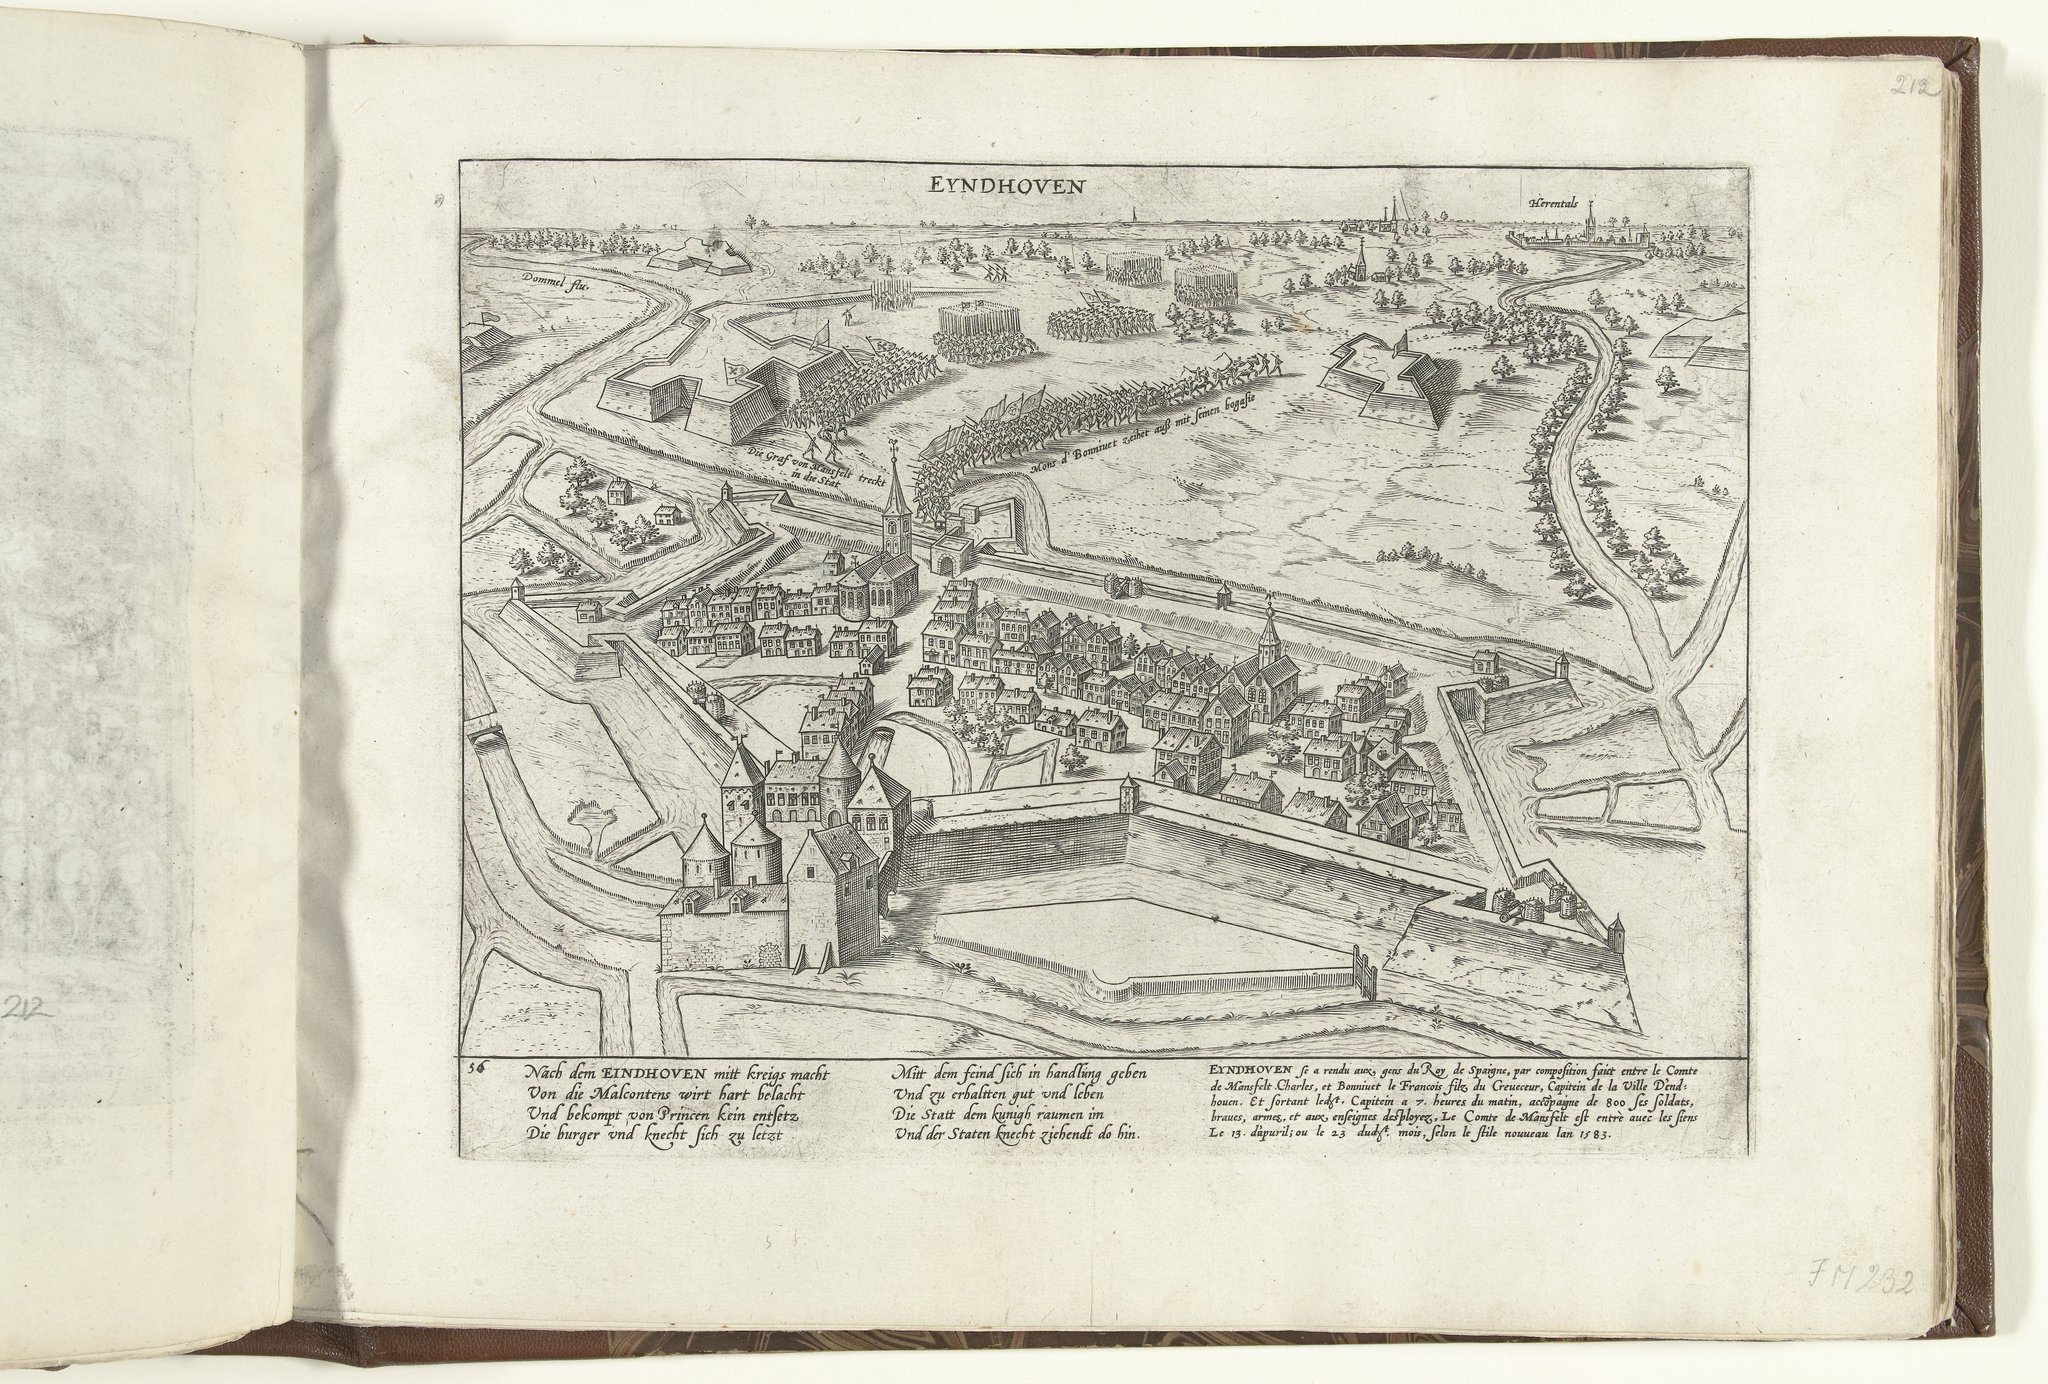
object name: album leaf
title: Eindhoven belegerd en ingenomen, 1583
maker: frans hogenberg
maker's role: print maker, publisher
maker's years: 1538-1590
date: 1583-1585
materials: paper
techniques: engraving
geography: cologne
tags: capture of city (after the siege)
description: Eindhoven belegerd en ingenomen door de graaf van Mansveld, 23 april 1583. De troepen onder Bonnivet verlaten de stad en de troepen van Mansveld staan klaar om de stad in te trekken. Met onderschrift van 8 regels in het Duits en 5 regels in het Frans. Genummerd: 56.